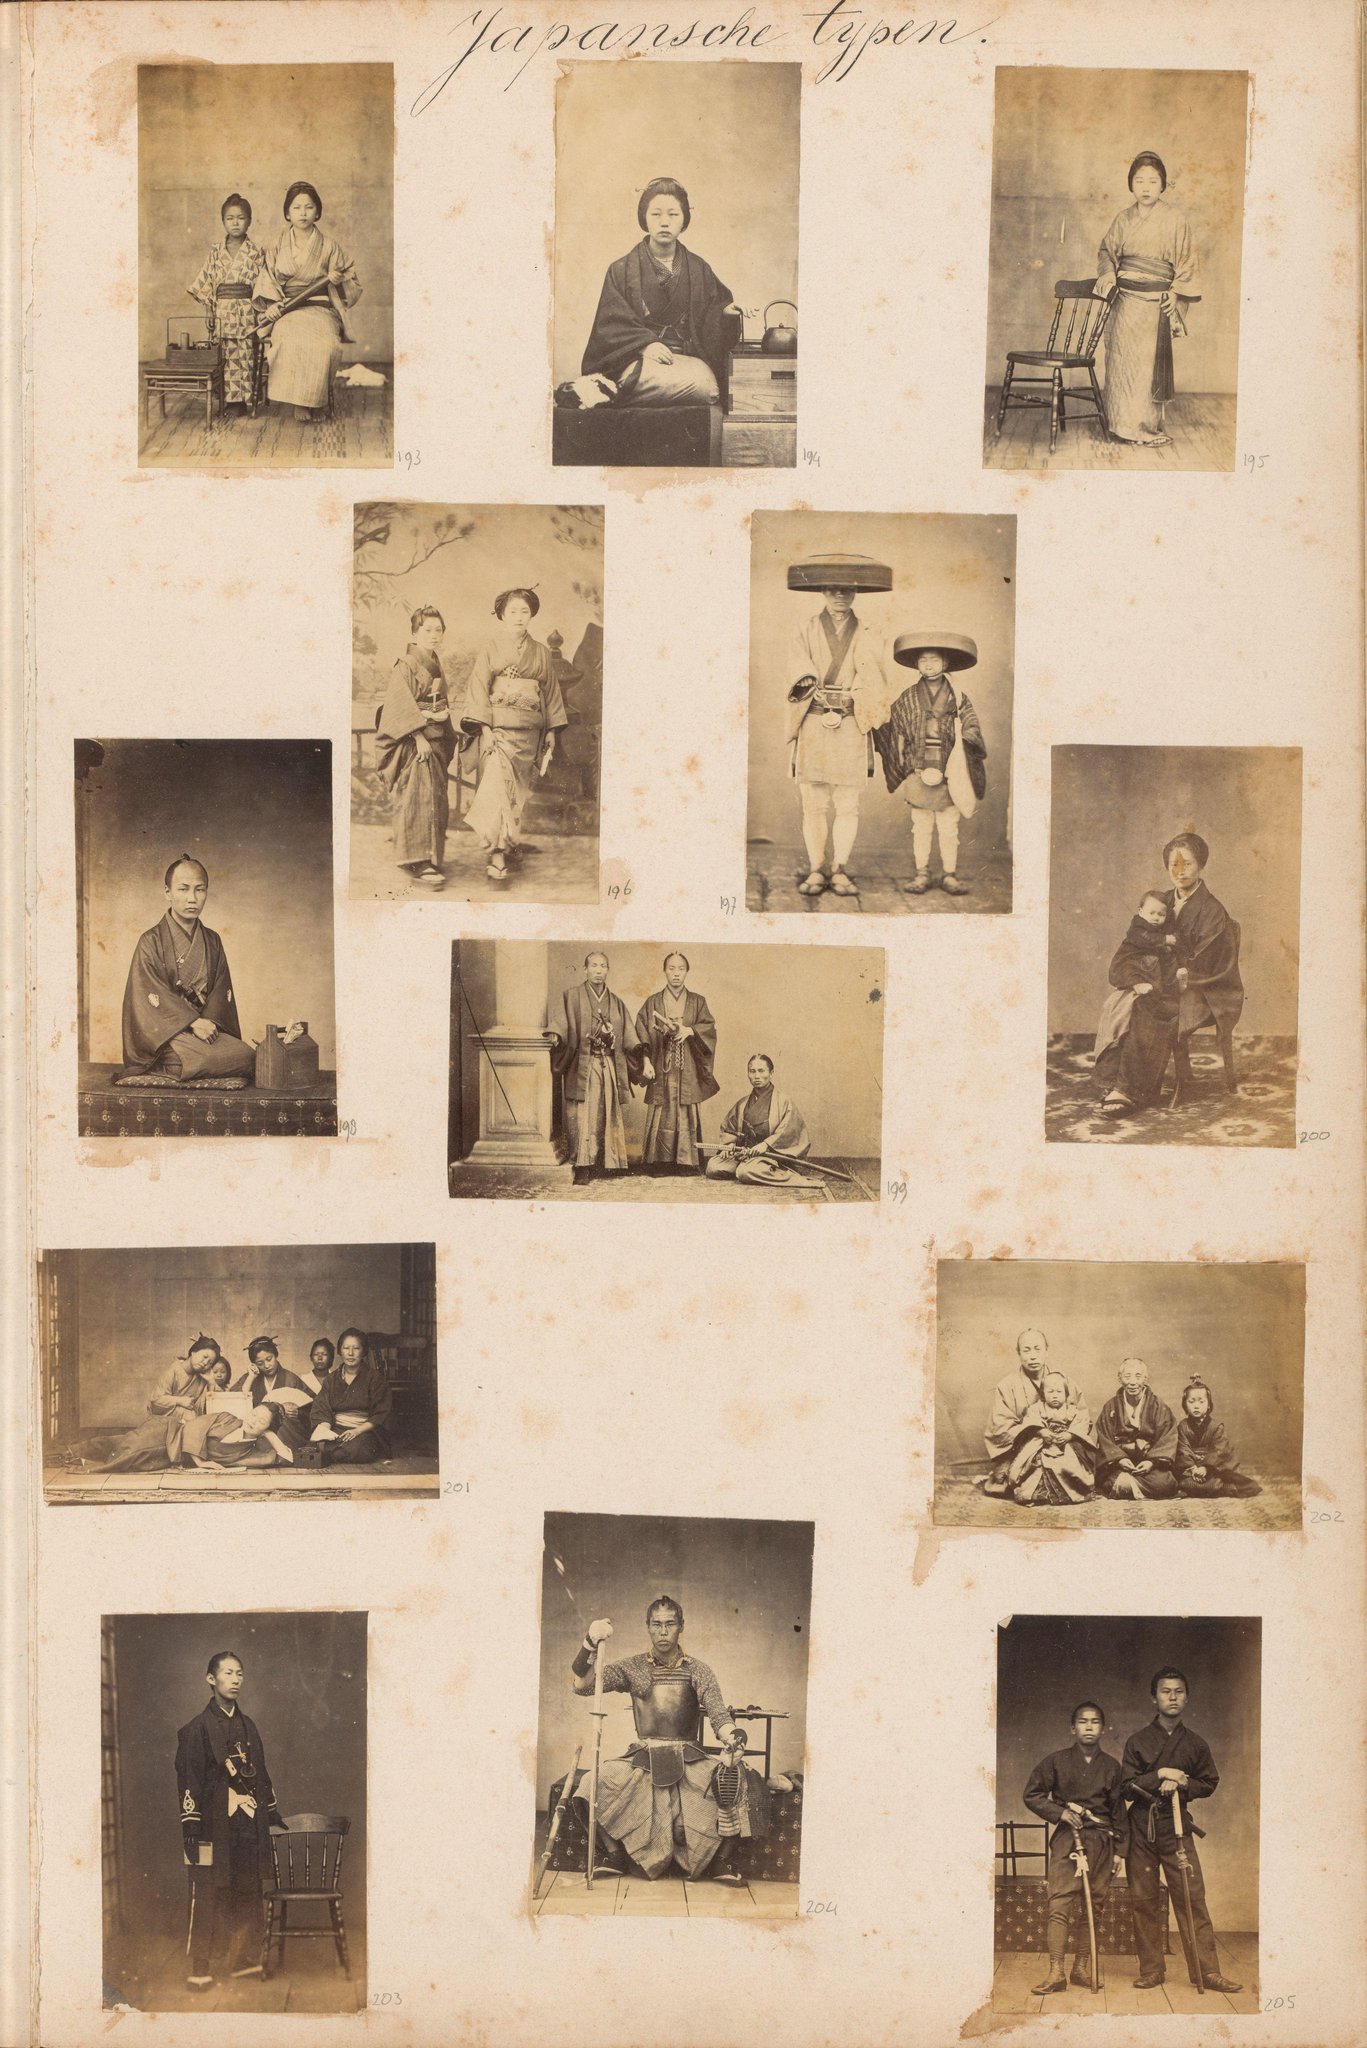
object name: photograph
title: Portret van twee Japanse mannen met grote platte hoeden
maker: Anonymous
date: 1870-1880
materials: paper, photographic support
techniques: albumen print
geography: japan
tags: studio requisites ~ photographer, head-gear, adult man, youth, adolescent, japan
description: Onderdeel van Fotoalbum van Robert Daniel Crommelin (1841-1907).